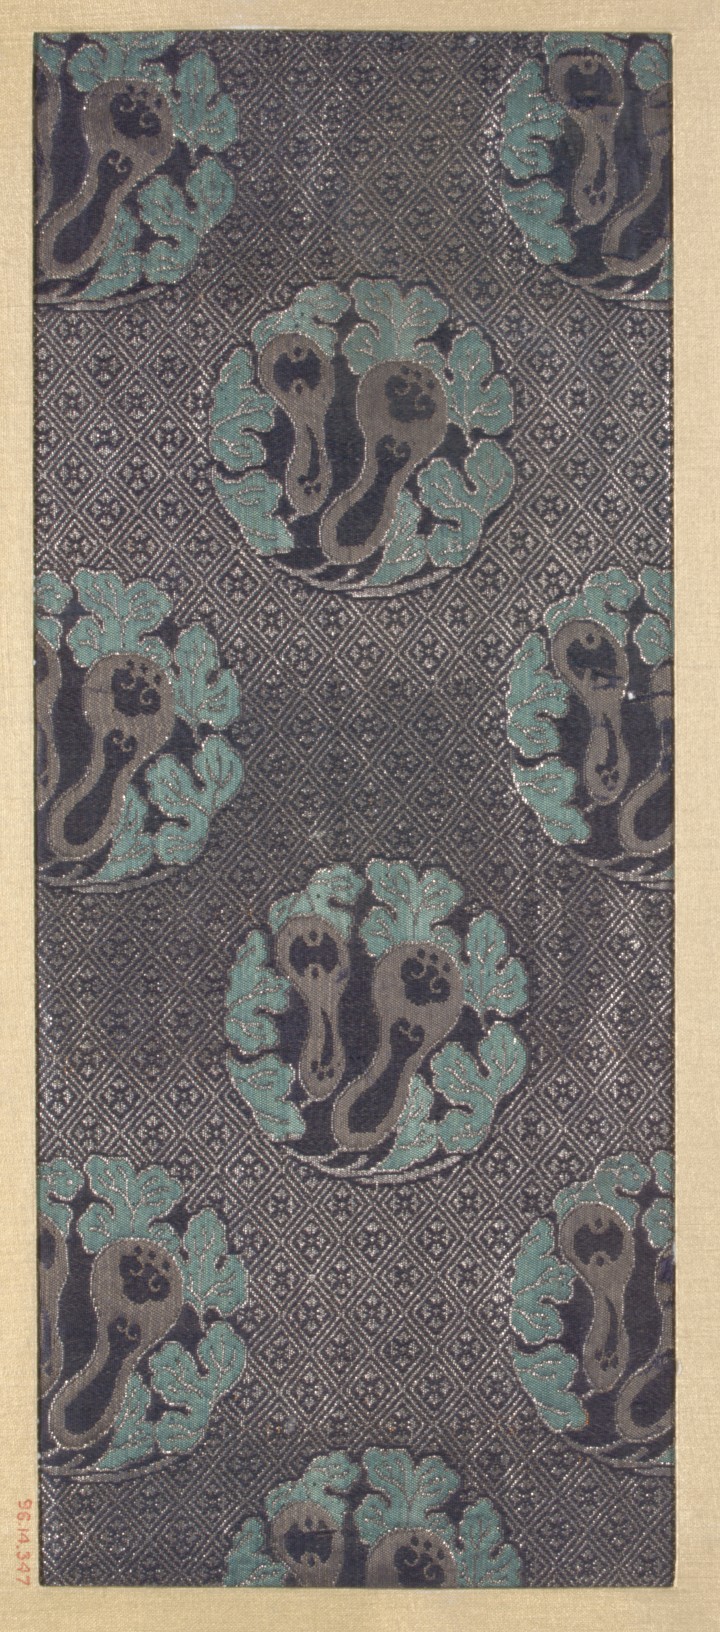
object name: piece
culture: japanese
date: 1701-1900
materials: silk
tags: gourds